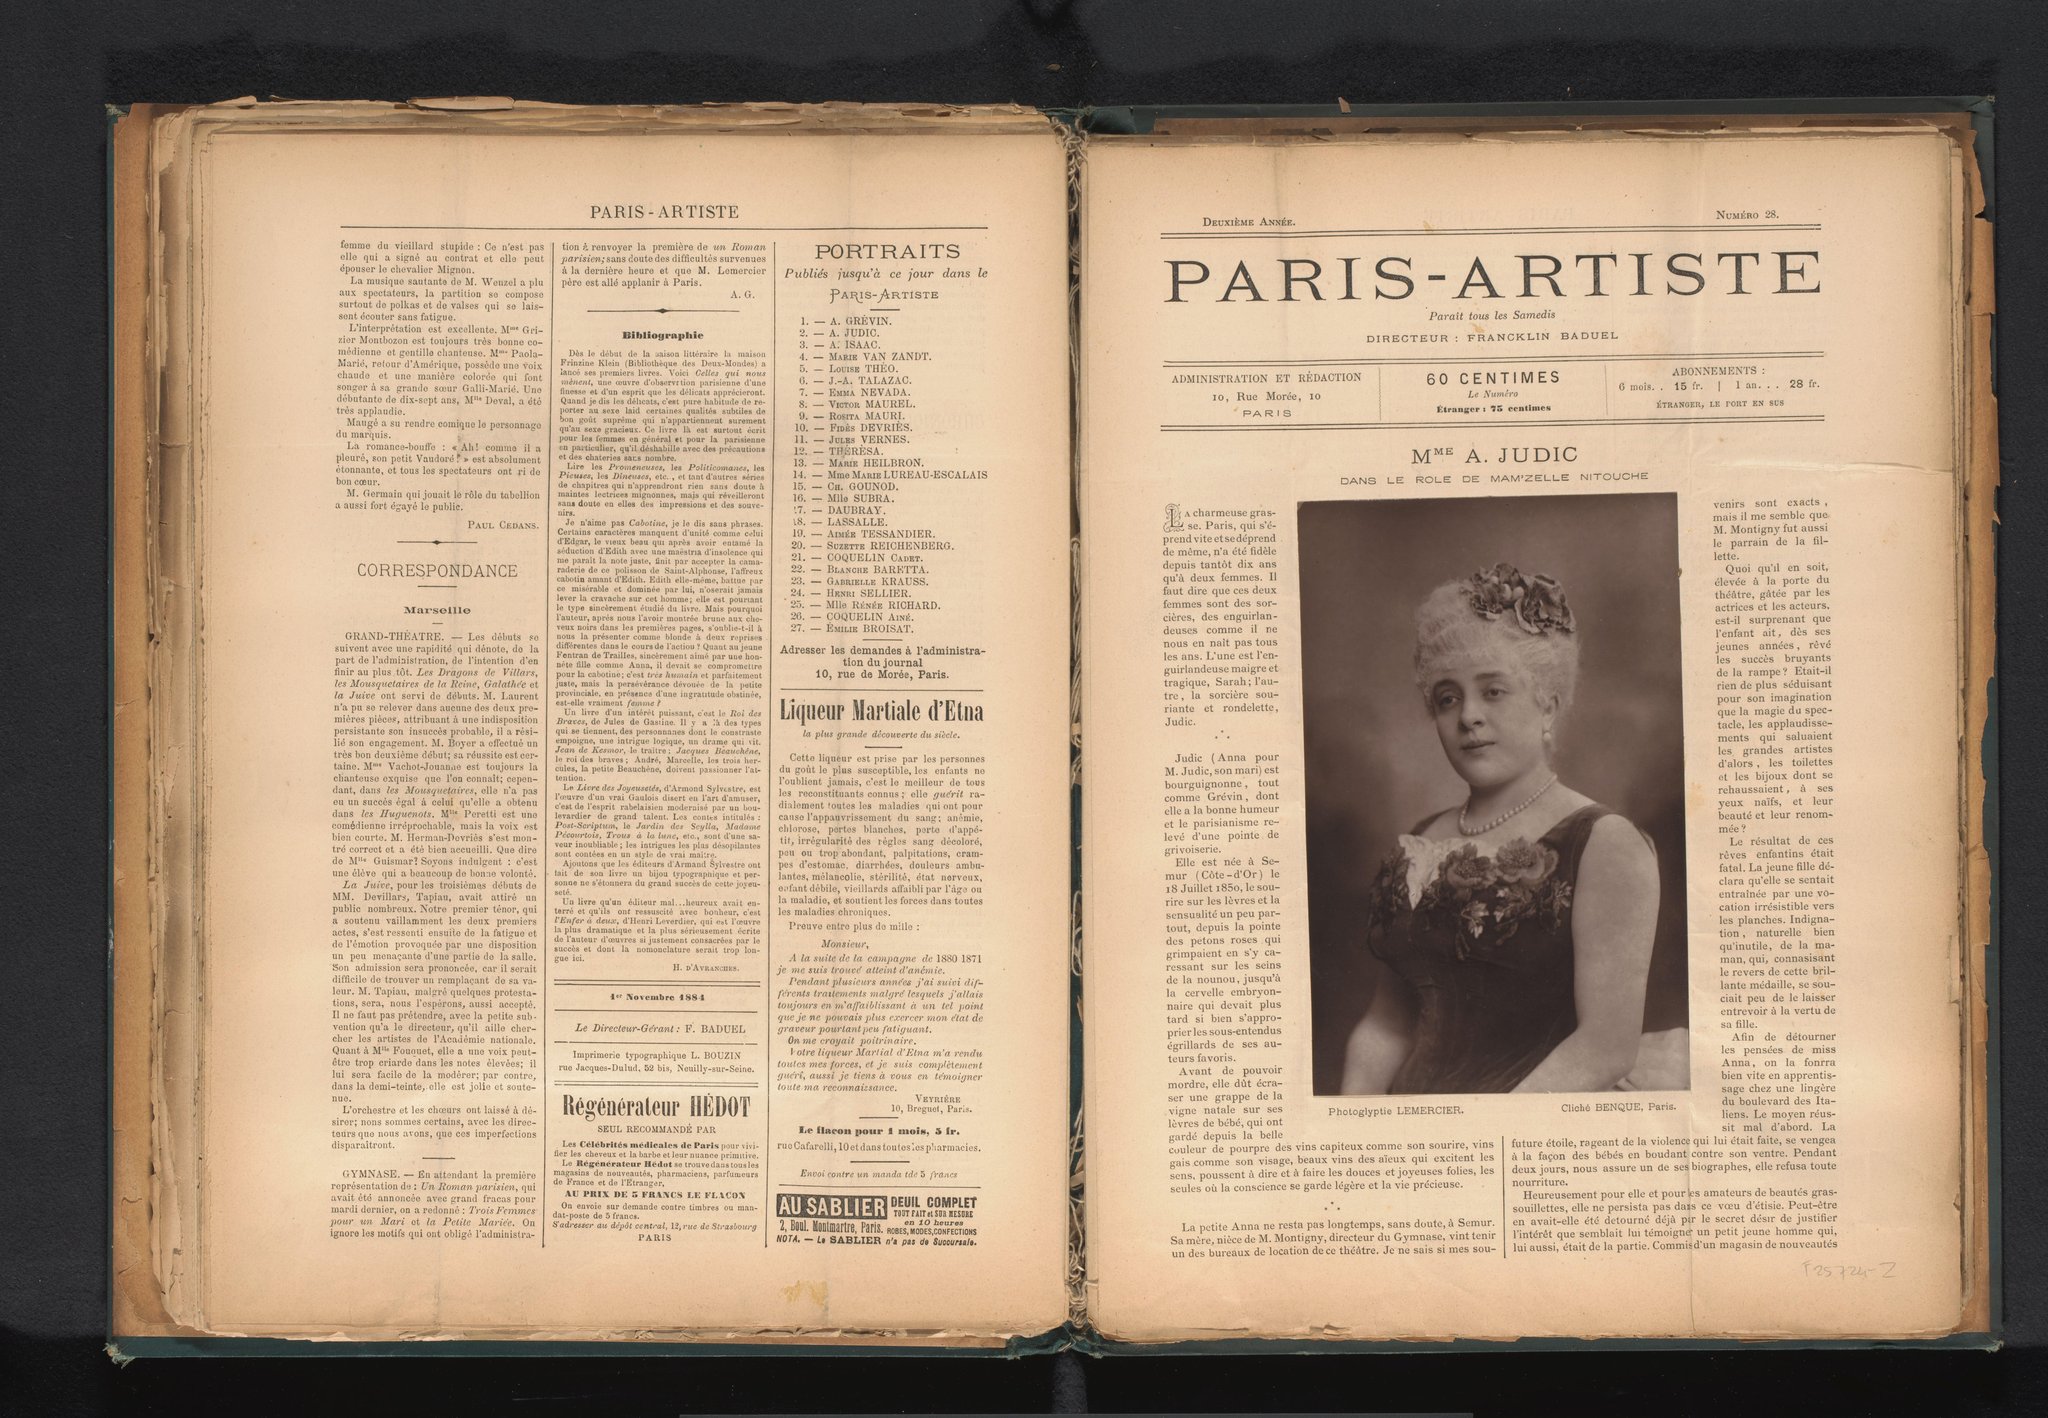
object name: page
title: Portret van Anna Judic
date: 1880-1884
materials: paper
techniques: woodburytype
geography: paris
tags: historical persons - bb - woman, portrait of actor, actress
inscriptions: inscription: ‘Dans le role de mam'zelle Nitouche’